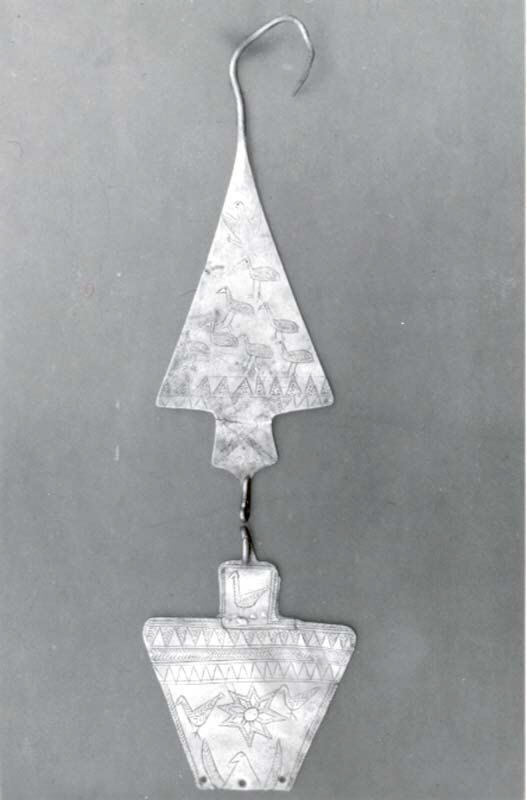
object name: pin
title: Pin fragment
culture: iranian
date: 700-601 BCE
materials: silver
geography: iran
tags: birds